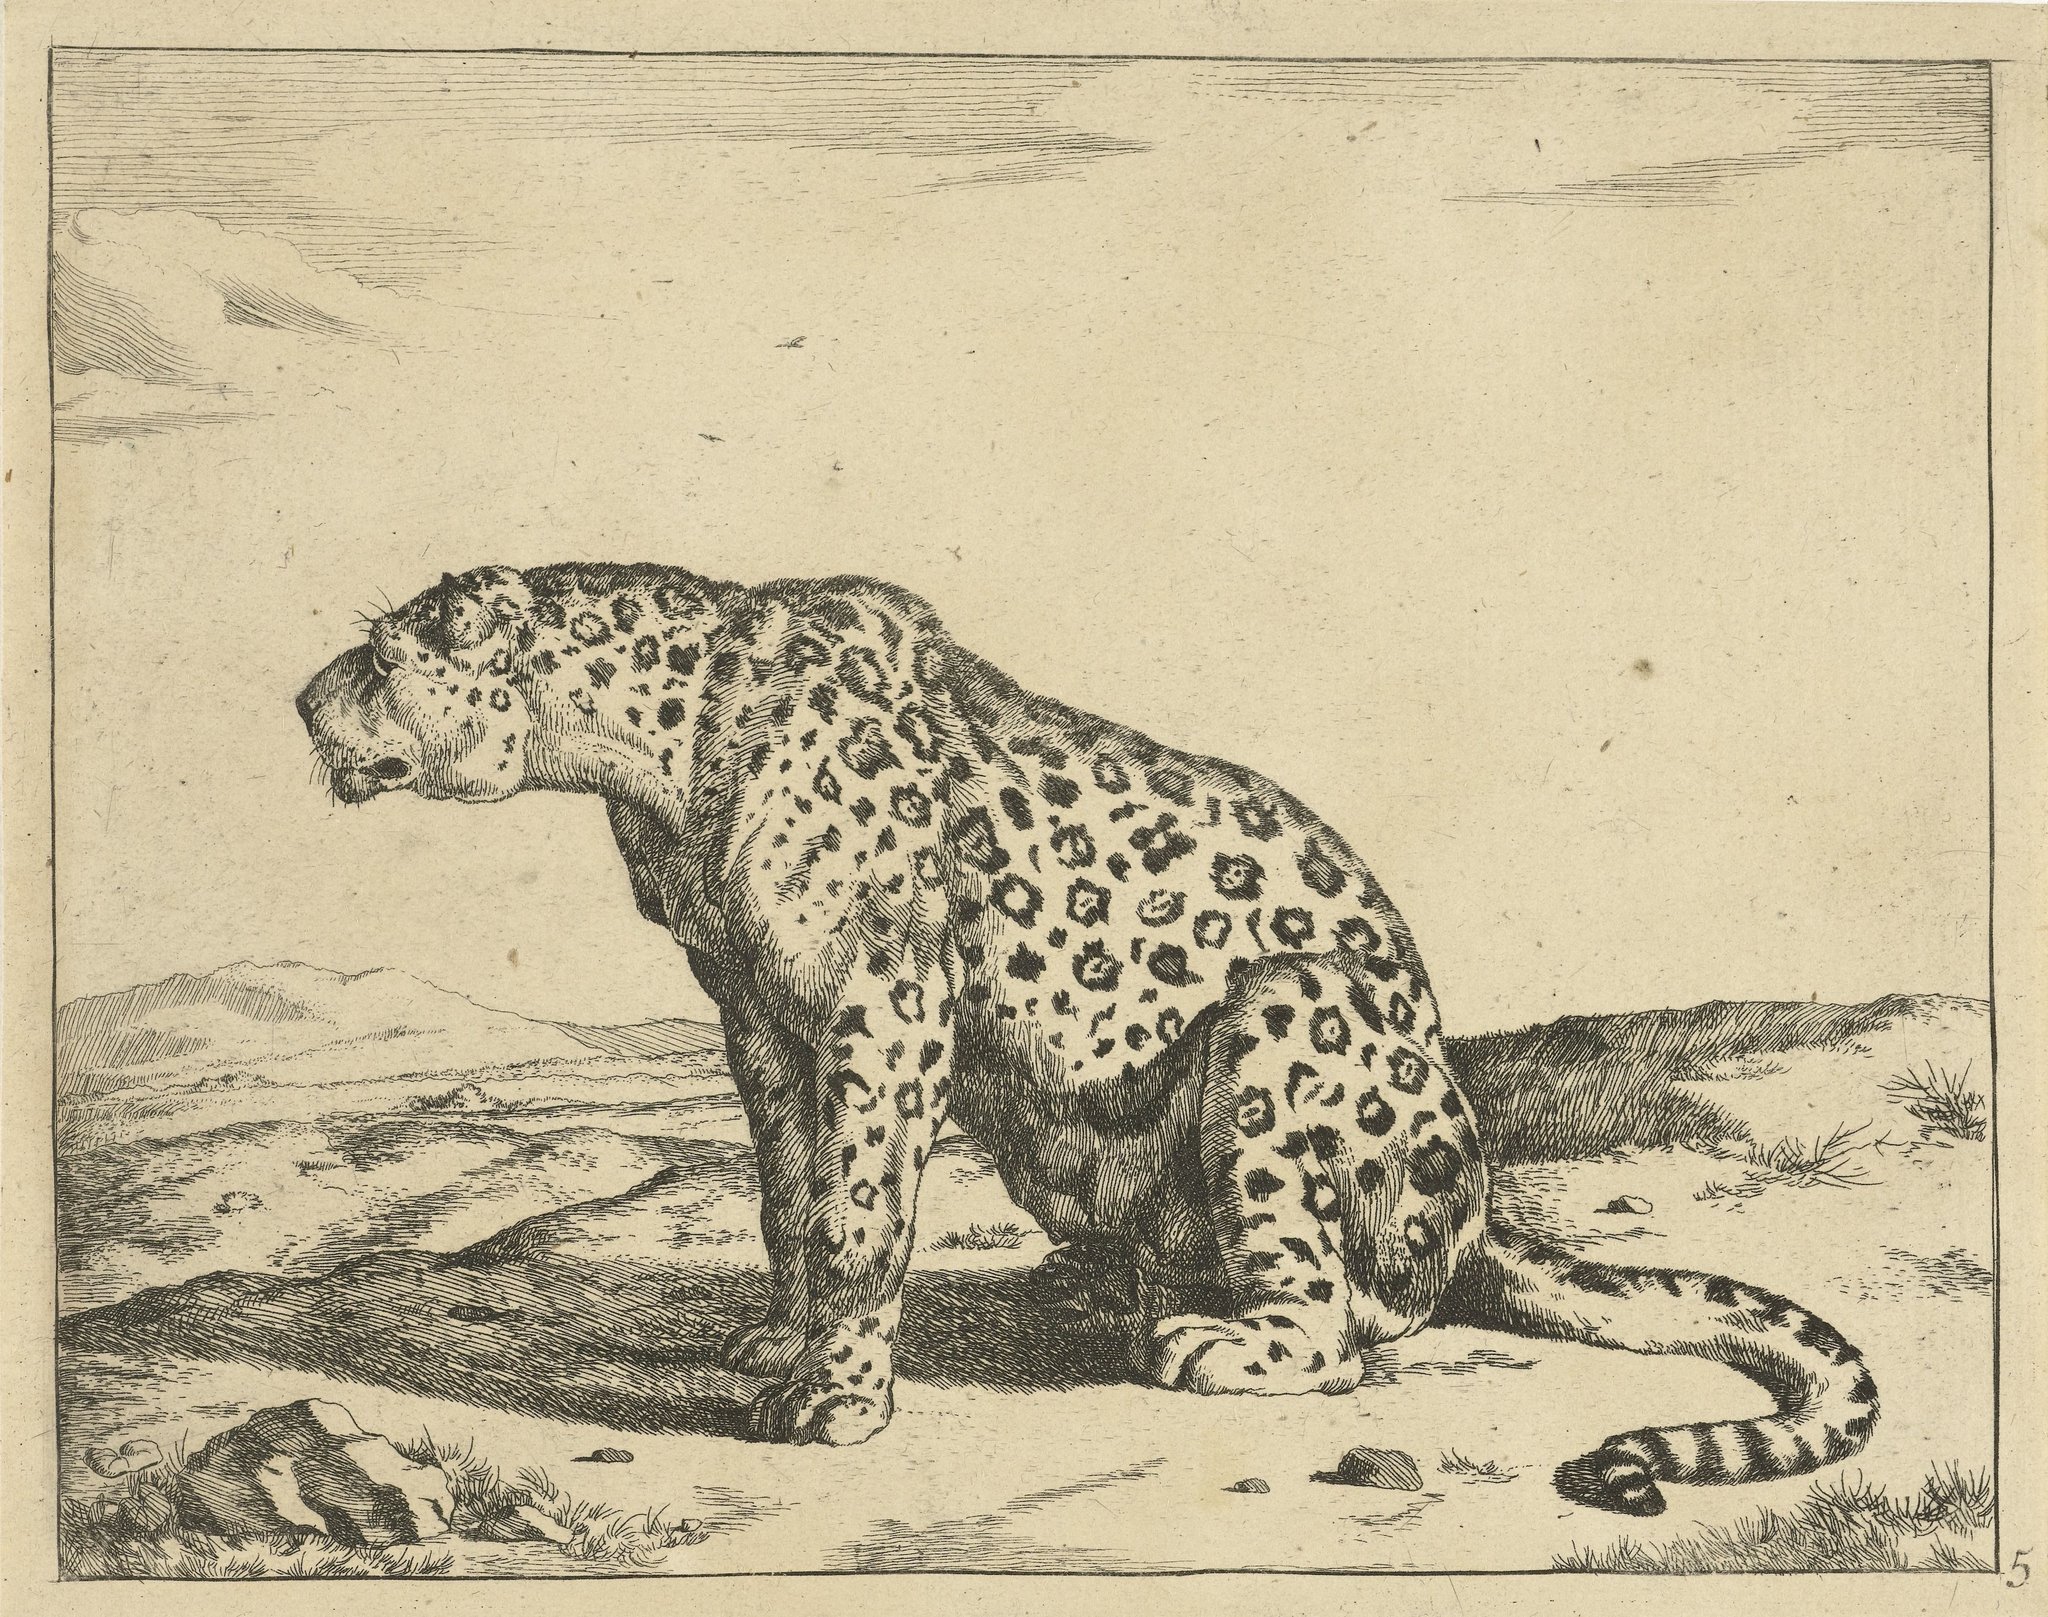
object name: print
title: Luipaard zittend op achterpoten, naar links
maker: marcus de bye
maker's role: print maker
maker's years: 1639-1688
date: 1657-1677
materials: paper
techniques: etching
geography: the hague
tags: beasts of prey, predatory animals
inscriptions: collector's mark: Lugt 2228